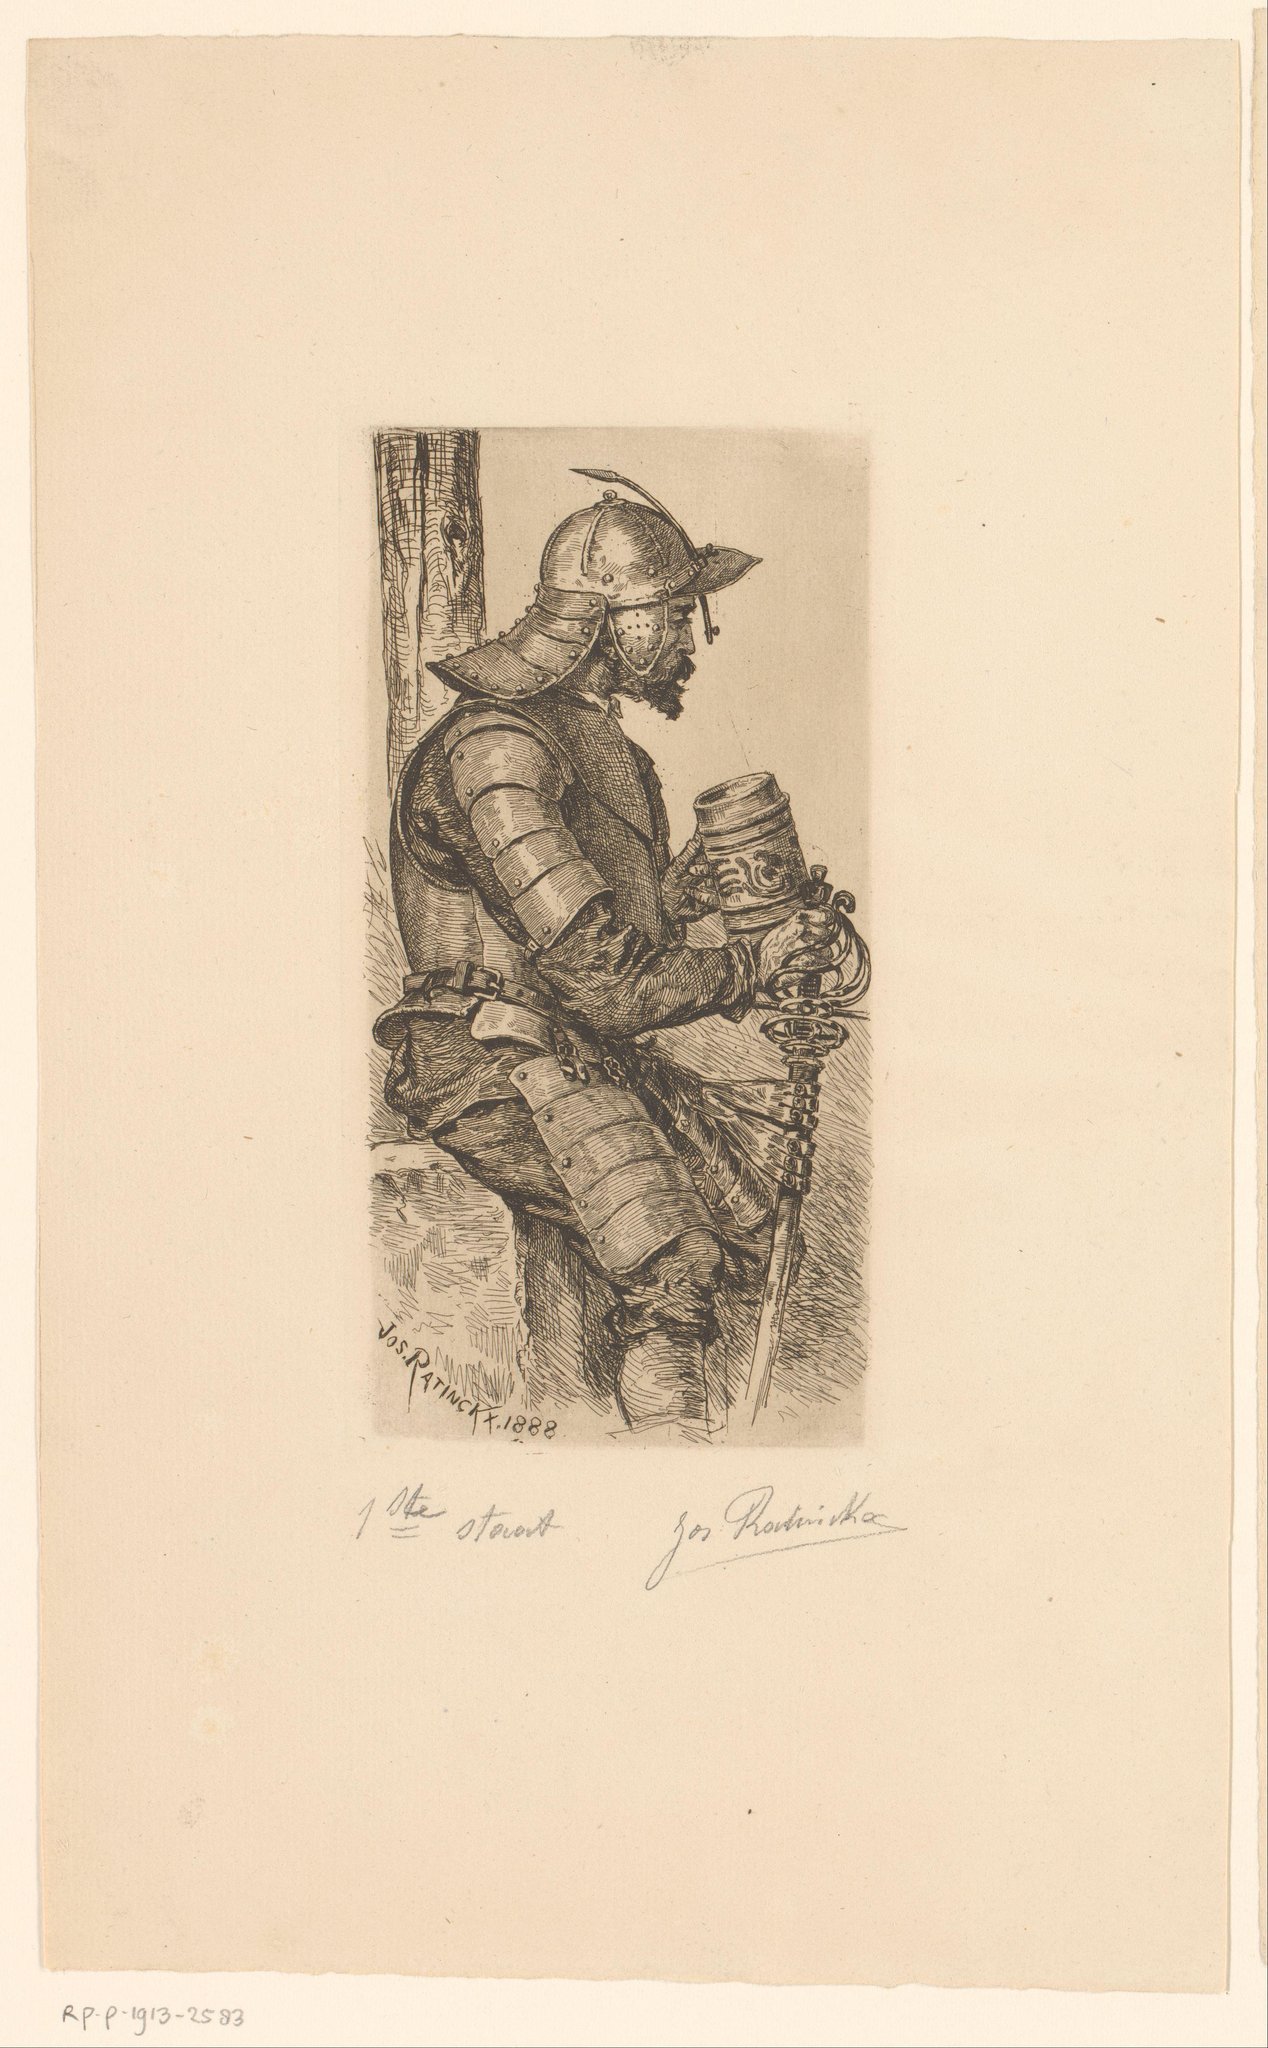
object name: print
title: Man in harnas met zwaard en pul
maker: jos ratinckx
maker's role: print maker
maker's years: 1860-1937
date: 1888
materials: paper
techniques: etching, intaglio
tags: armour, hacking and thrusting weapons: sword, drinking-vessels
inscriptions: collector's mark: Lugt 2228, inscription: ‘1ste staat’